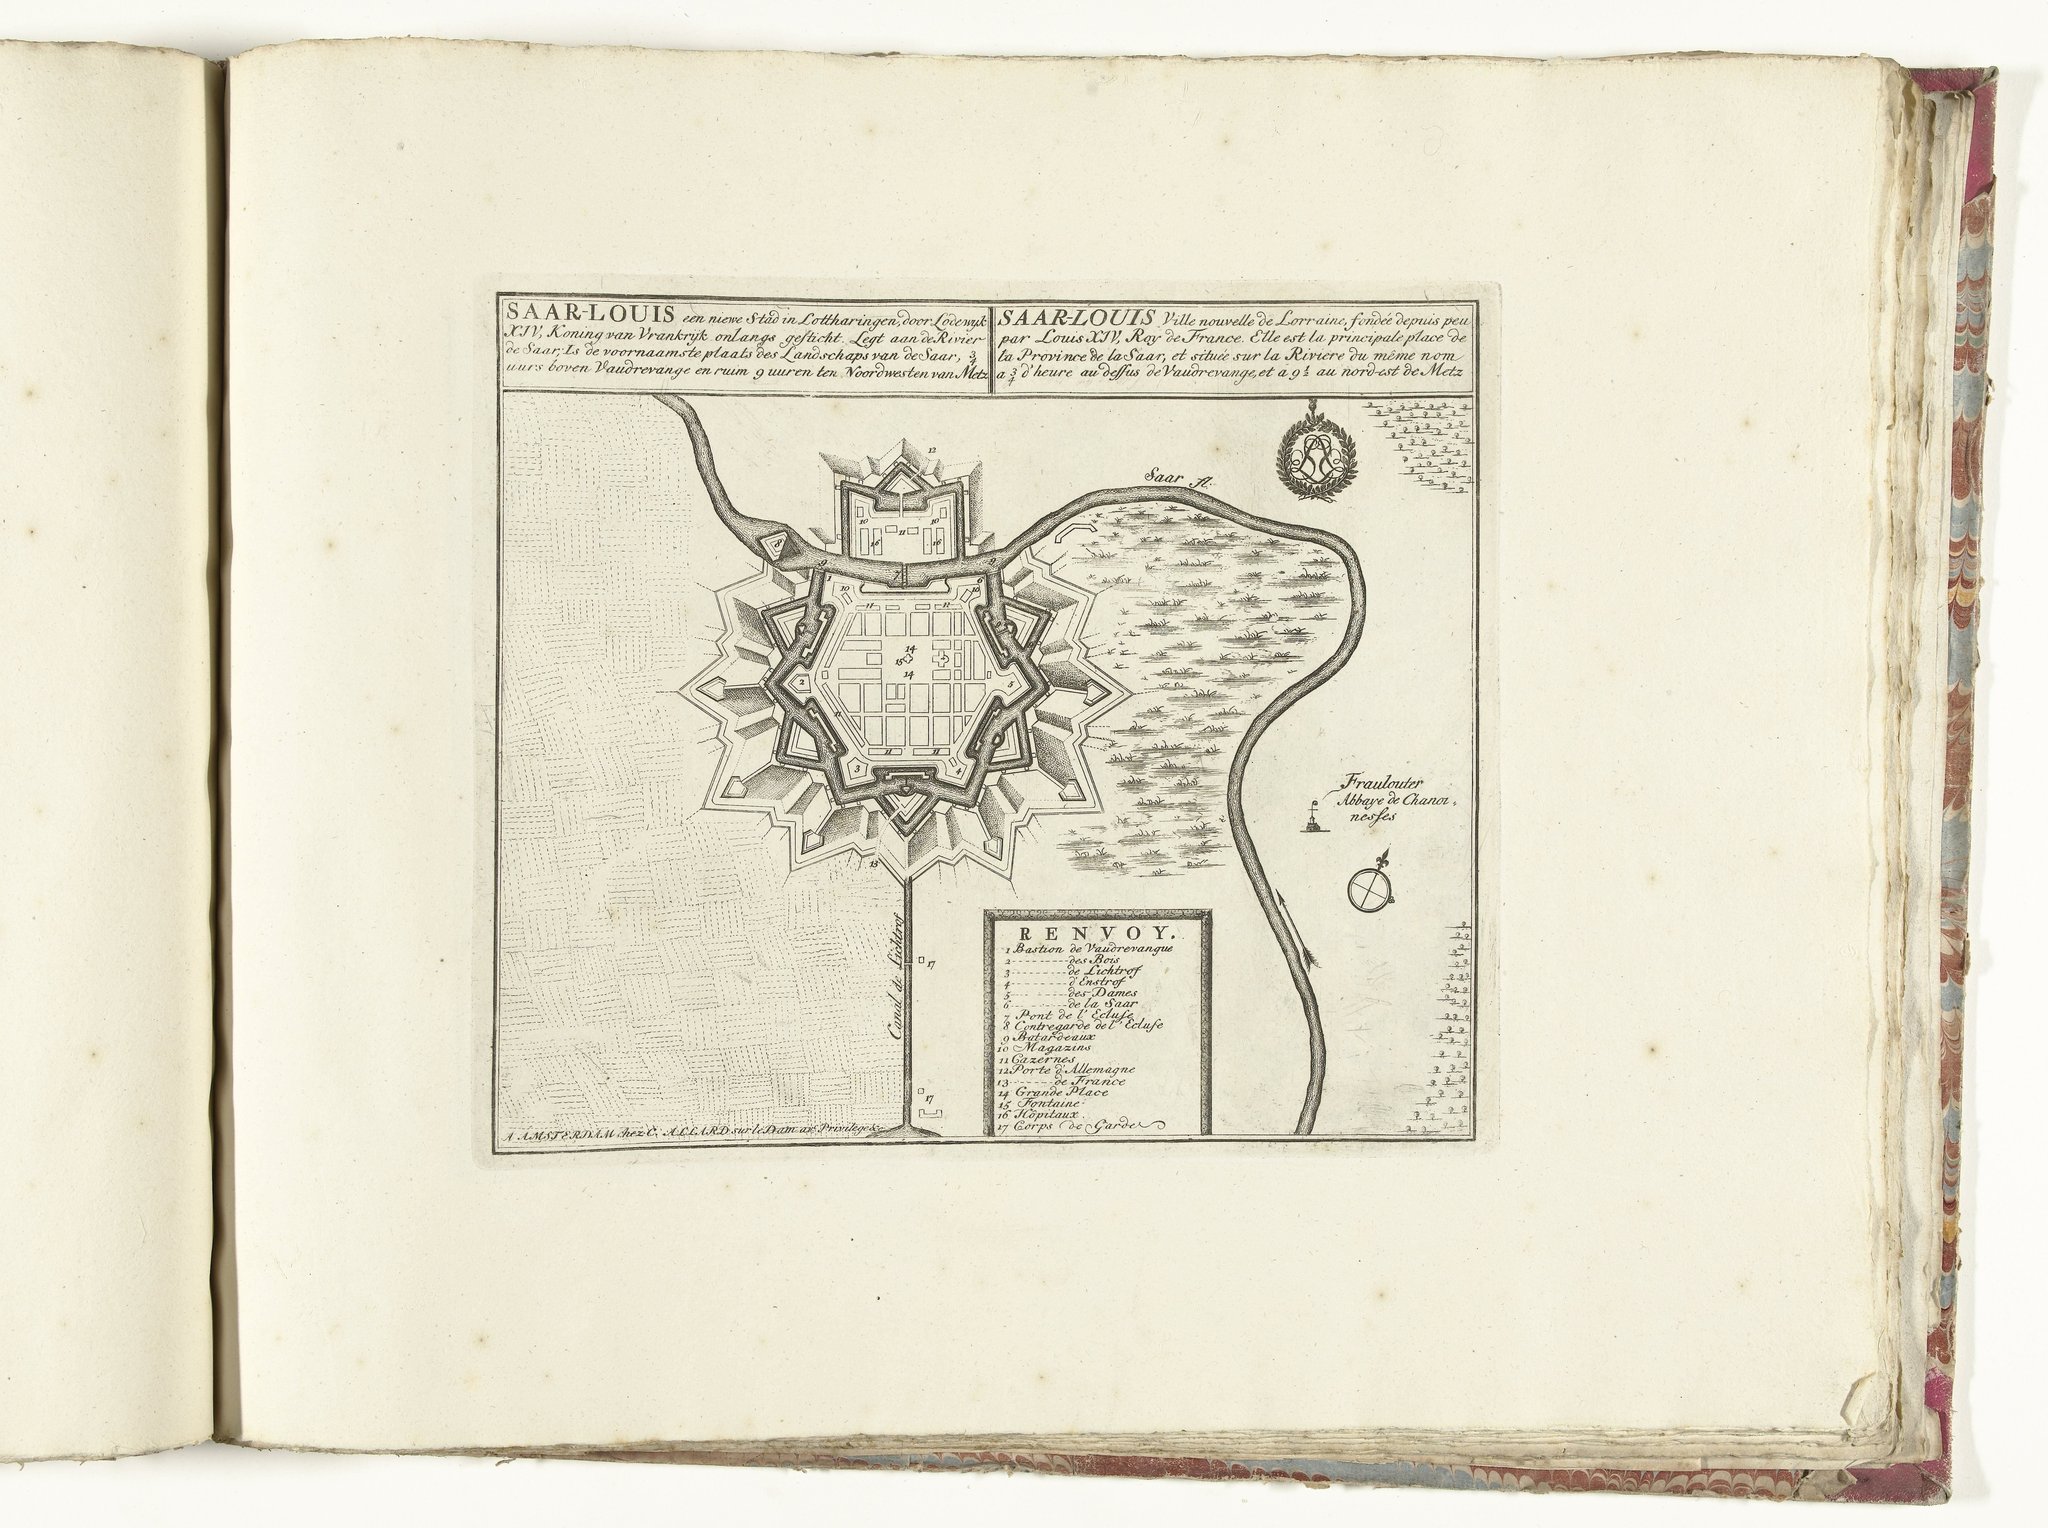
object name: album leaf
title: Les Principales Forteresses & Villes Fortes, d'Espagne, de France, d'Italie, de Savoië, d'Allemagne & des Païs-Bas (...) / Naaukeurige Afbeeldingen der Voornaamste Sterke Steden en Vestingen in Spanjen, Vrankryk, Italien, Savoyen, Duytsland en Nederlanden (...)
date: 1701-1714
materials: paper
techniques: etching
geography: france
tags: maps of cities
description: Gekopieerd naar de Franse prenten in: Nicolas de Fer, Les forces de l'Europe, ou description des principales villes, avec leurs fortifications : dessignées par les meilleurs ingenieurs, particulierement celles ... de la France, dont les plans ont esté levez par M. de Vauban, Nicolas de Fer, Parijs 1693-1696, of andere voorbeelden.